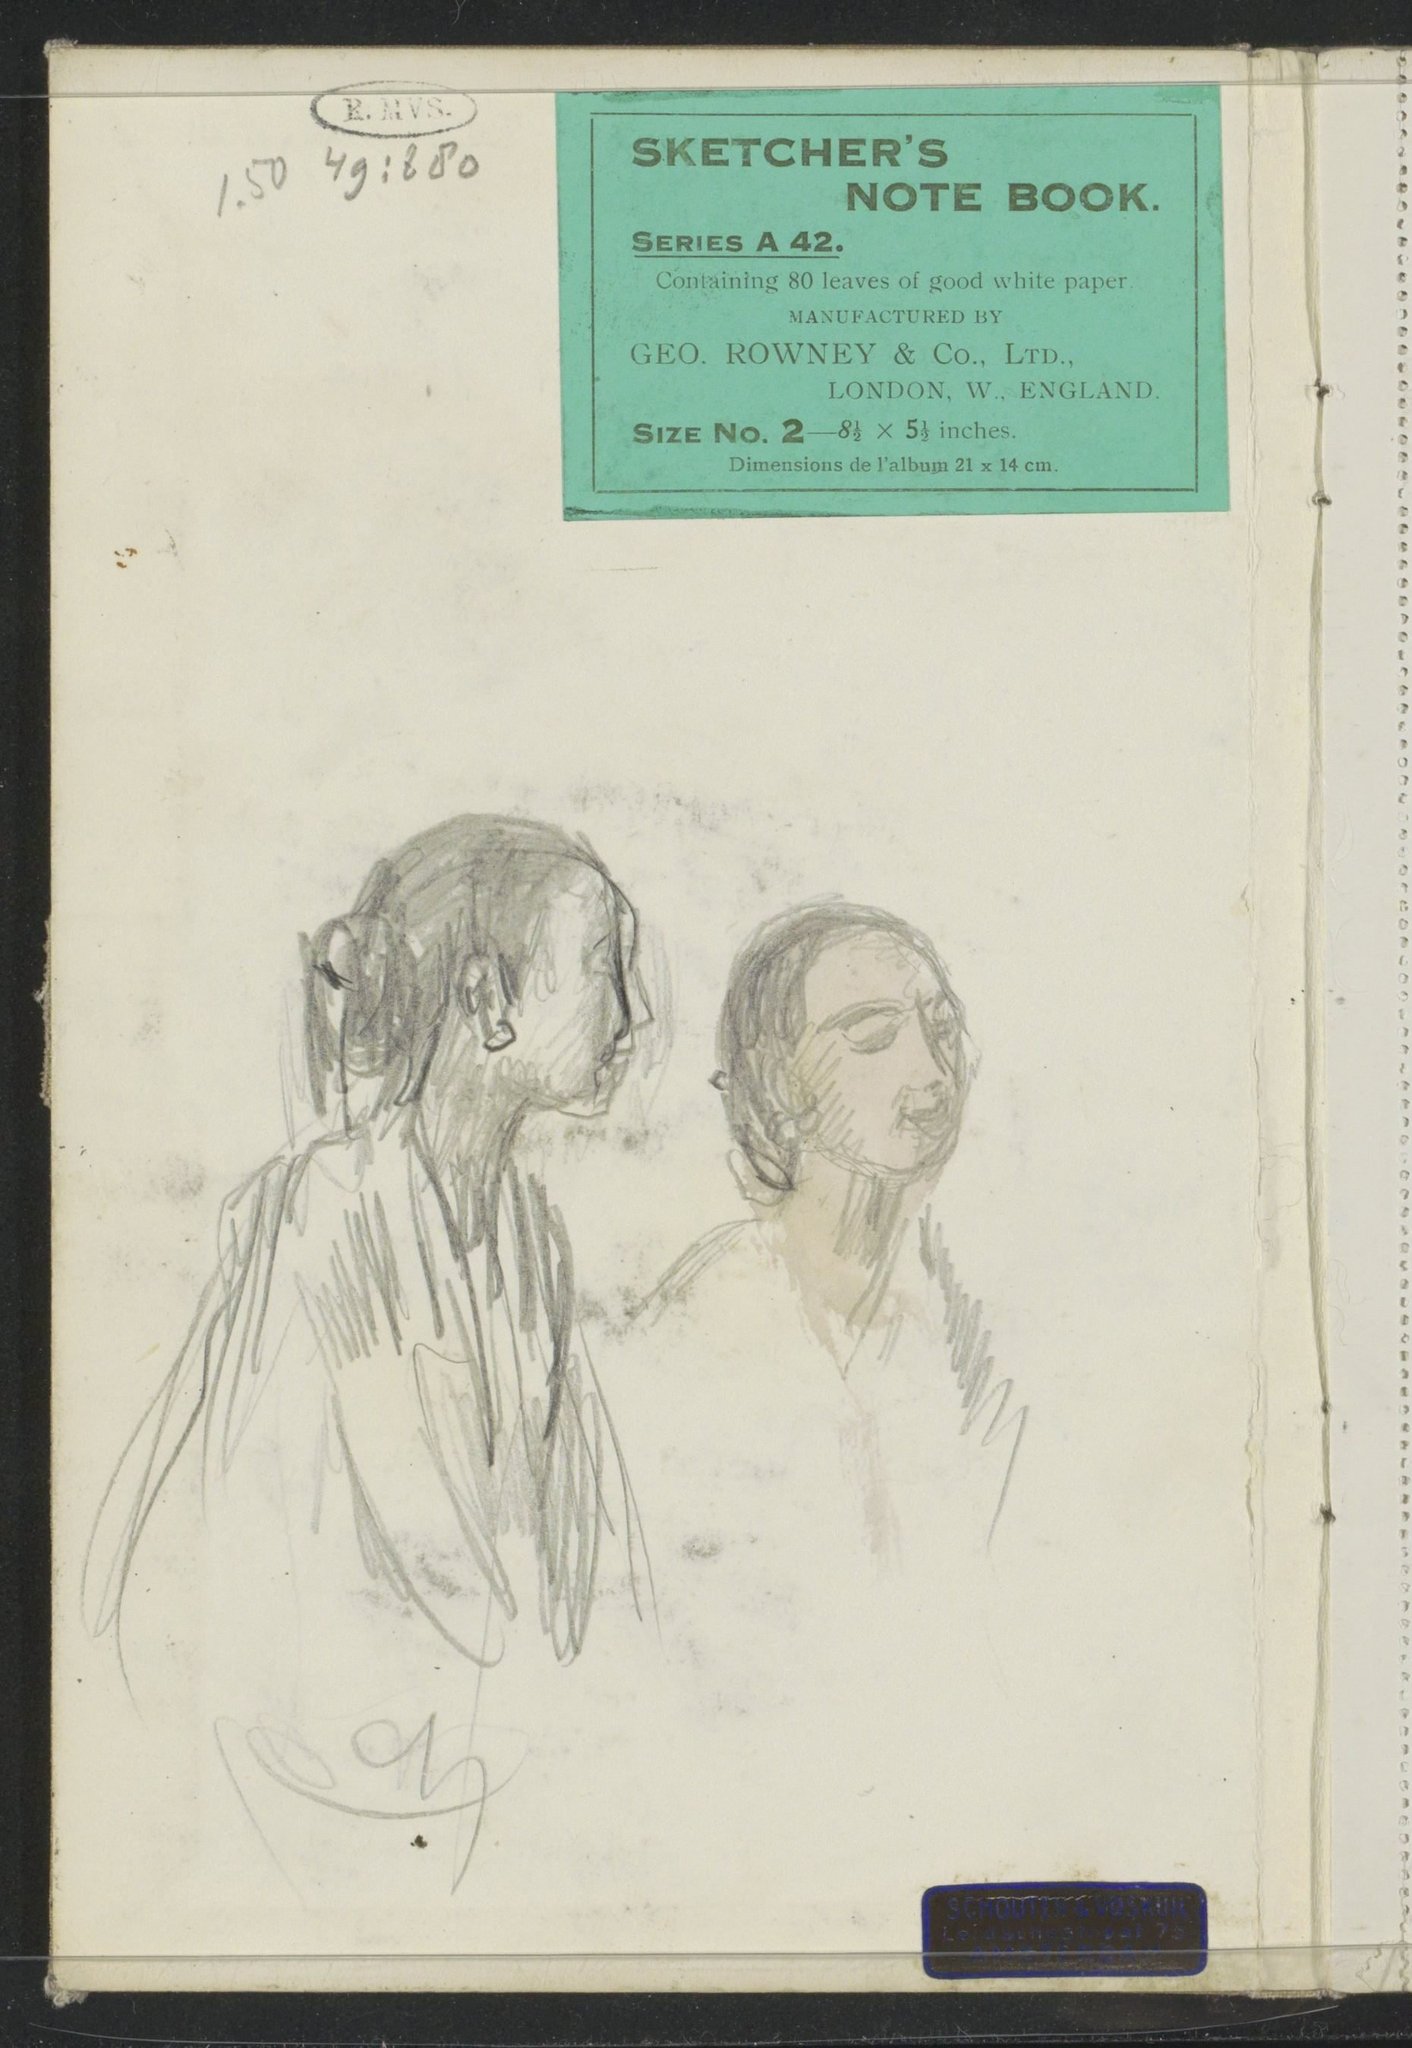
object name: endleaf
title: Twee Indonesische vrouwen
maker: marius bauer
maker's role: draughtsman, print maker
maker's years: 1867-1932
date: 1925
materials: paper, pencil, watercolor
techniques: brush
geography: indonesia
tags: asiatic races and peoples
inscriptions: retailer's mark: ‘SKETCHER'S/ NOTE BOOK./ Series A 42./ containing 80 leaves of good white paper/ MANUFACTURED BY/ GEO. ROWNEY & Co.,/ LONDON, W., ENGLAND/ SIZE No. 2 - 8 1/2 x 5 1/2 inches./ Dimensions de l'album 21 x 14 cm.’, retailer's mark: ‘SCHOUTEN & VOSKUIL/ Leidschestraat 75./ AMSTERDAM’, collector's mark: Lugt 2228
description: Voorste schutblad uit een schetsboek met 74 bladen.